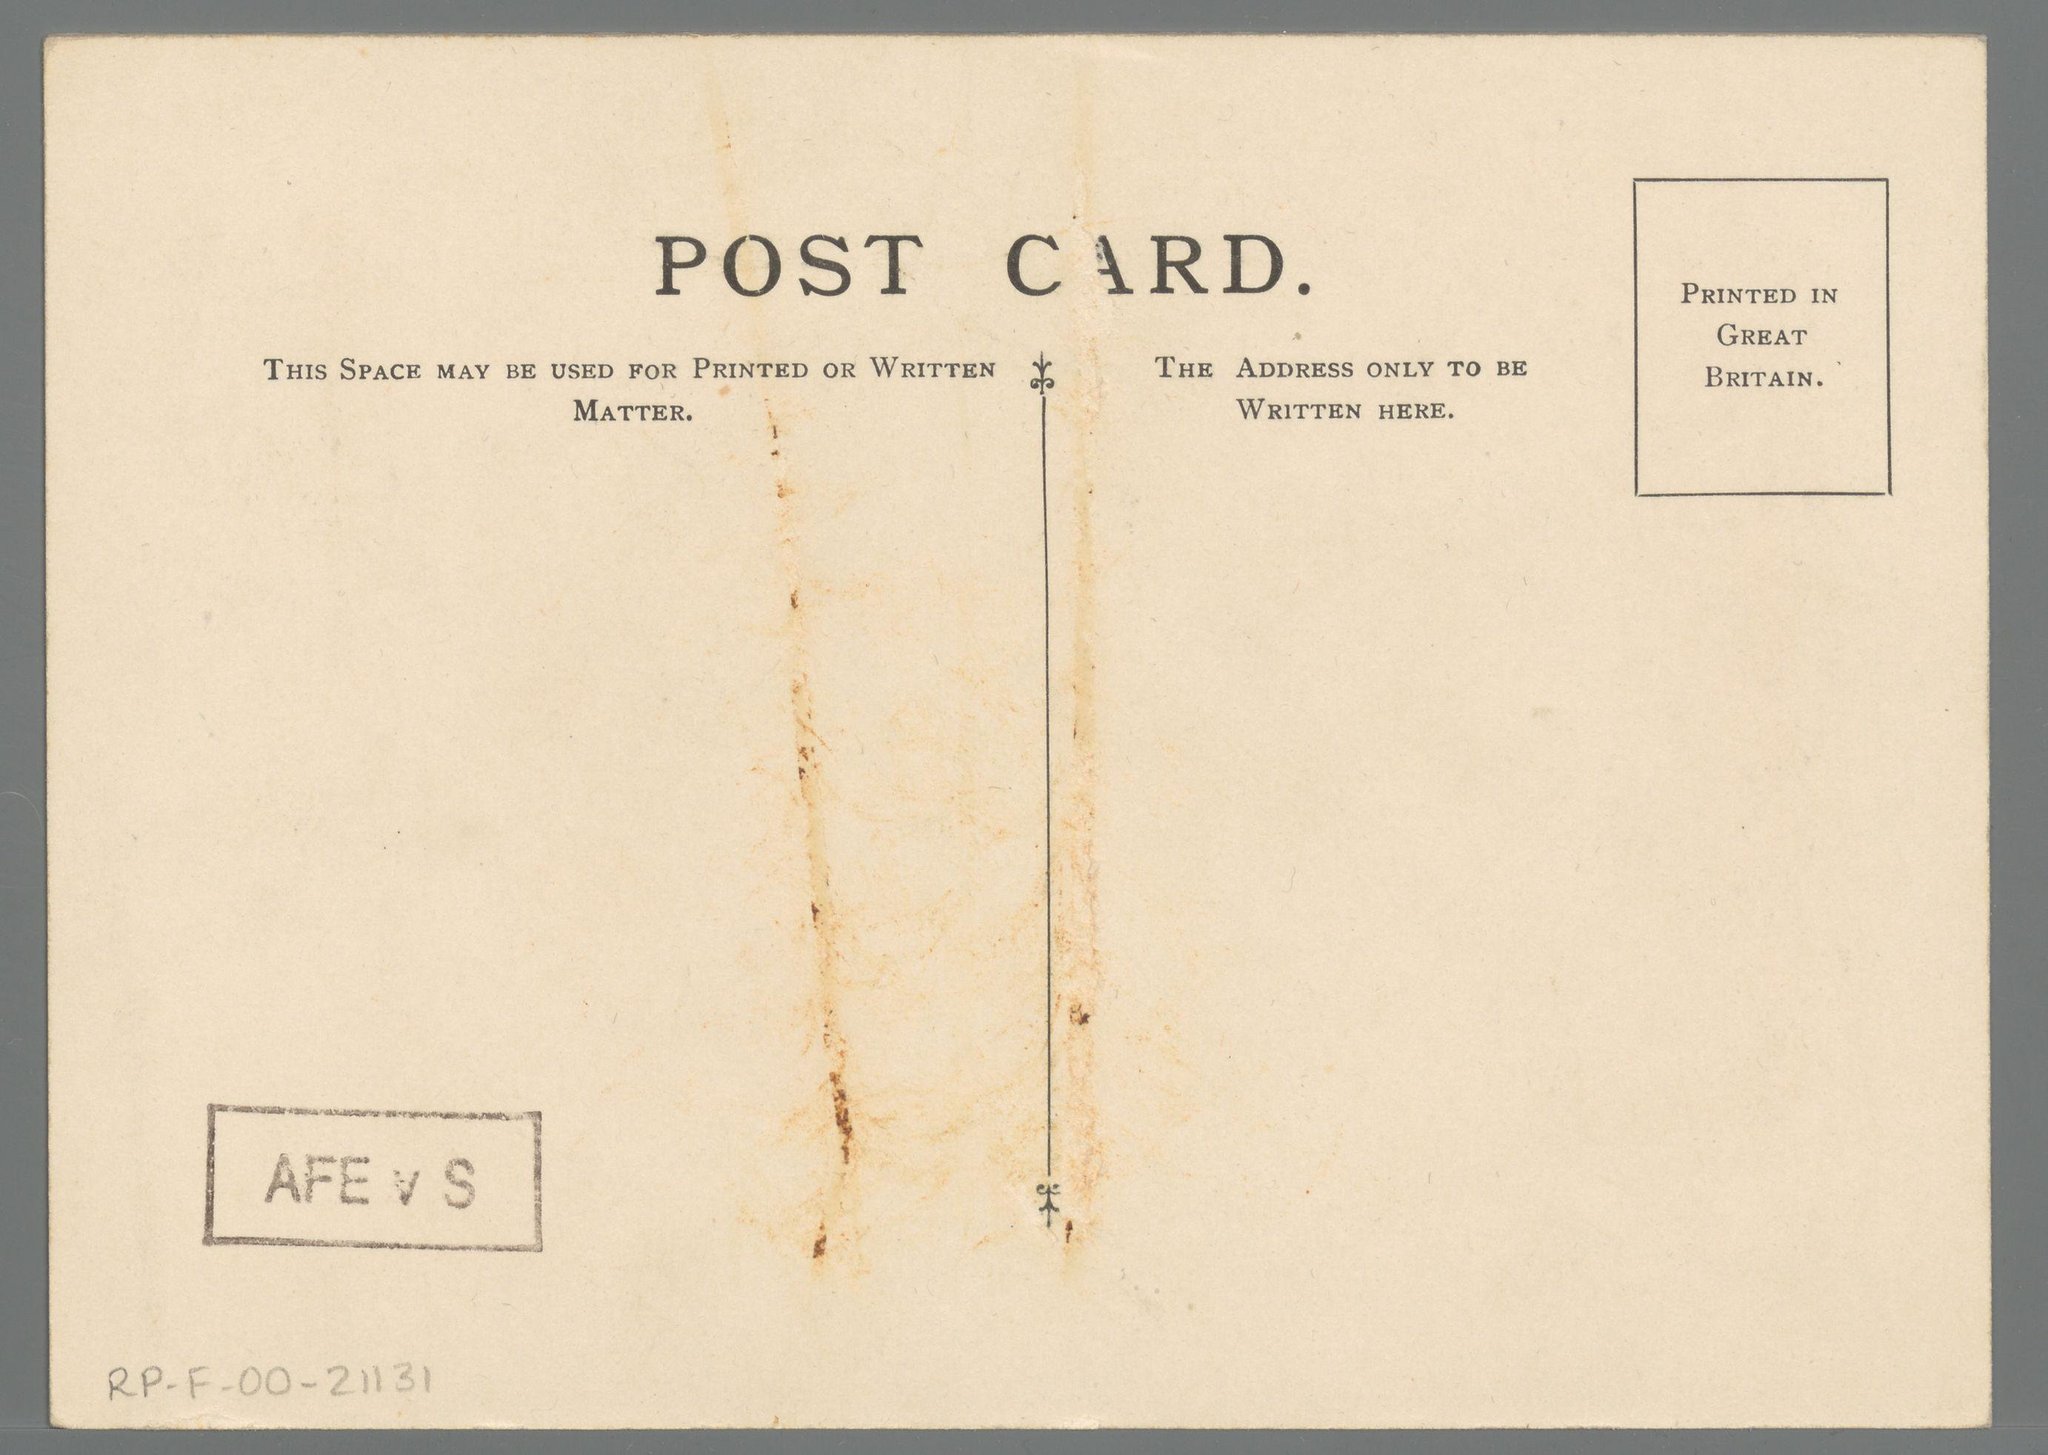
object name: ansichtkaart, prentbriefkaart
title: St. Bernardino of Siena. Italian, 15th cent. British Museum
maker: Anonymous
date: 1905-1950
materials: cardboard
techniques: color autotype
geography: london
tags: permanent exhibition, museum, picture, painting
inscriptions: collector's mark: ‘AFE v S’